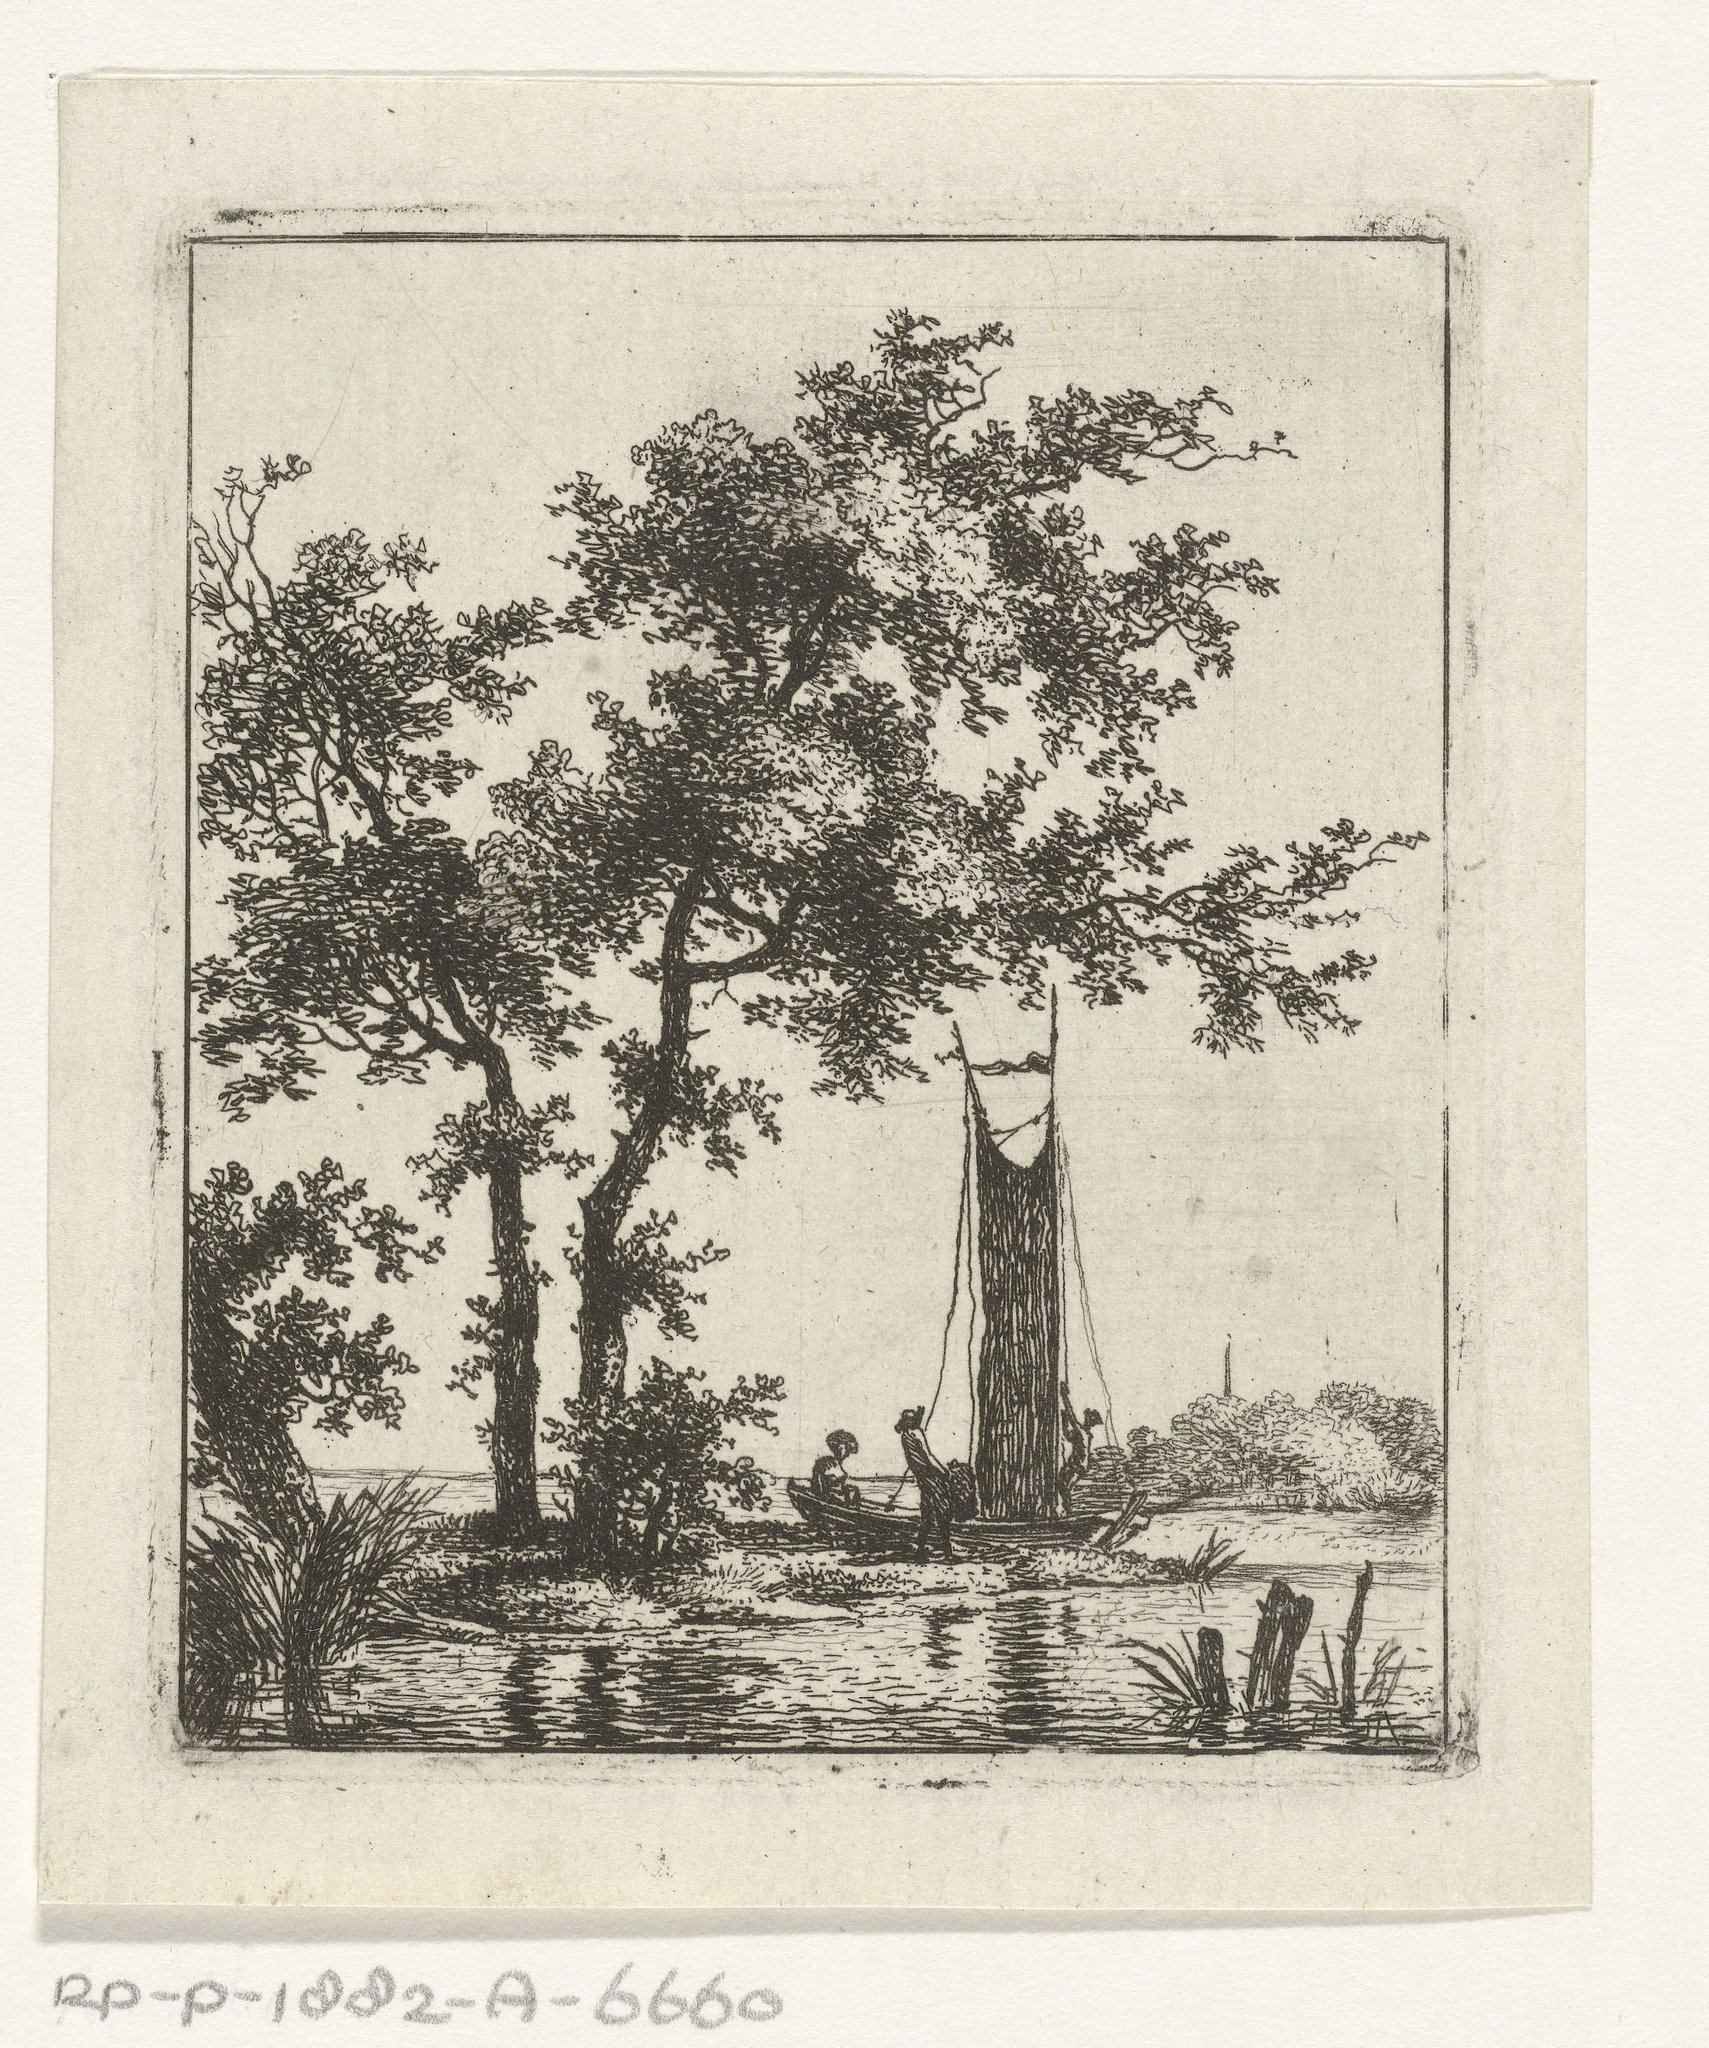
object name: print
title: Heisen van het zeil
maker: hermanus fock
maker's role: conservator, draughtsman, painter, print maker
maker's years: 1766-1822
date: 1781-1822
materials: paper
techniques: etching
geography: amsterdam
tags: sailing-ship, sailing-boat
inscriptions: collector's mark: Lugt 2228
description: Een rivierlandschap met een schuitje aan de waterkant, nabij twee bomen. In de boot twee personen, waarvan er één het zeil hijst. Een derde persoon staat op de oever.